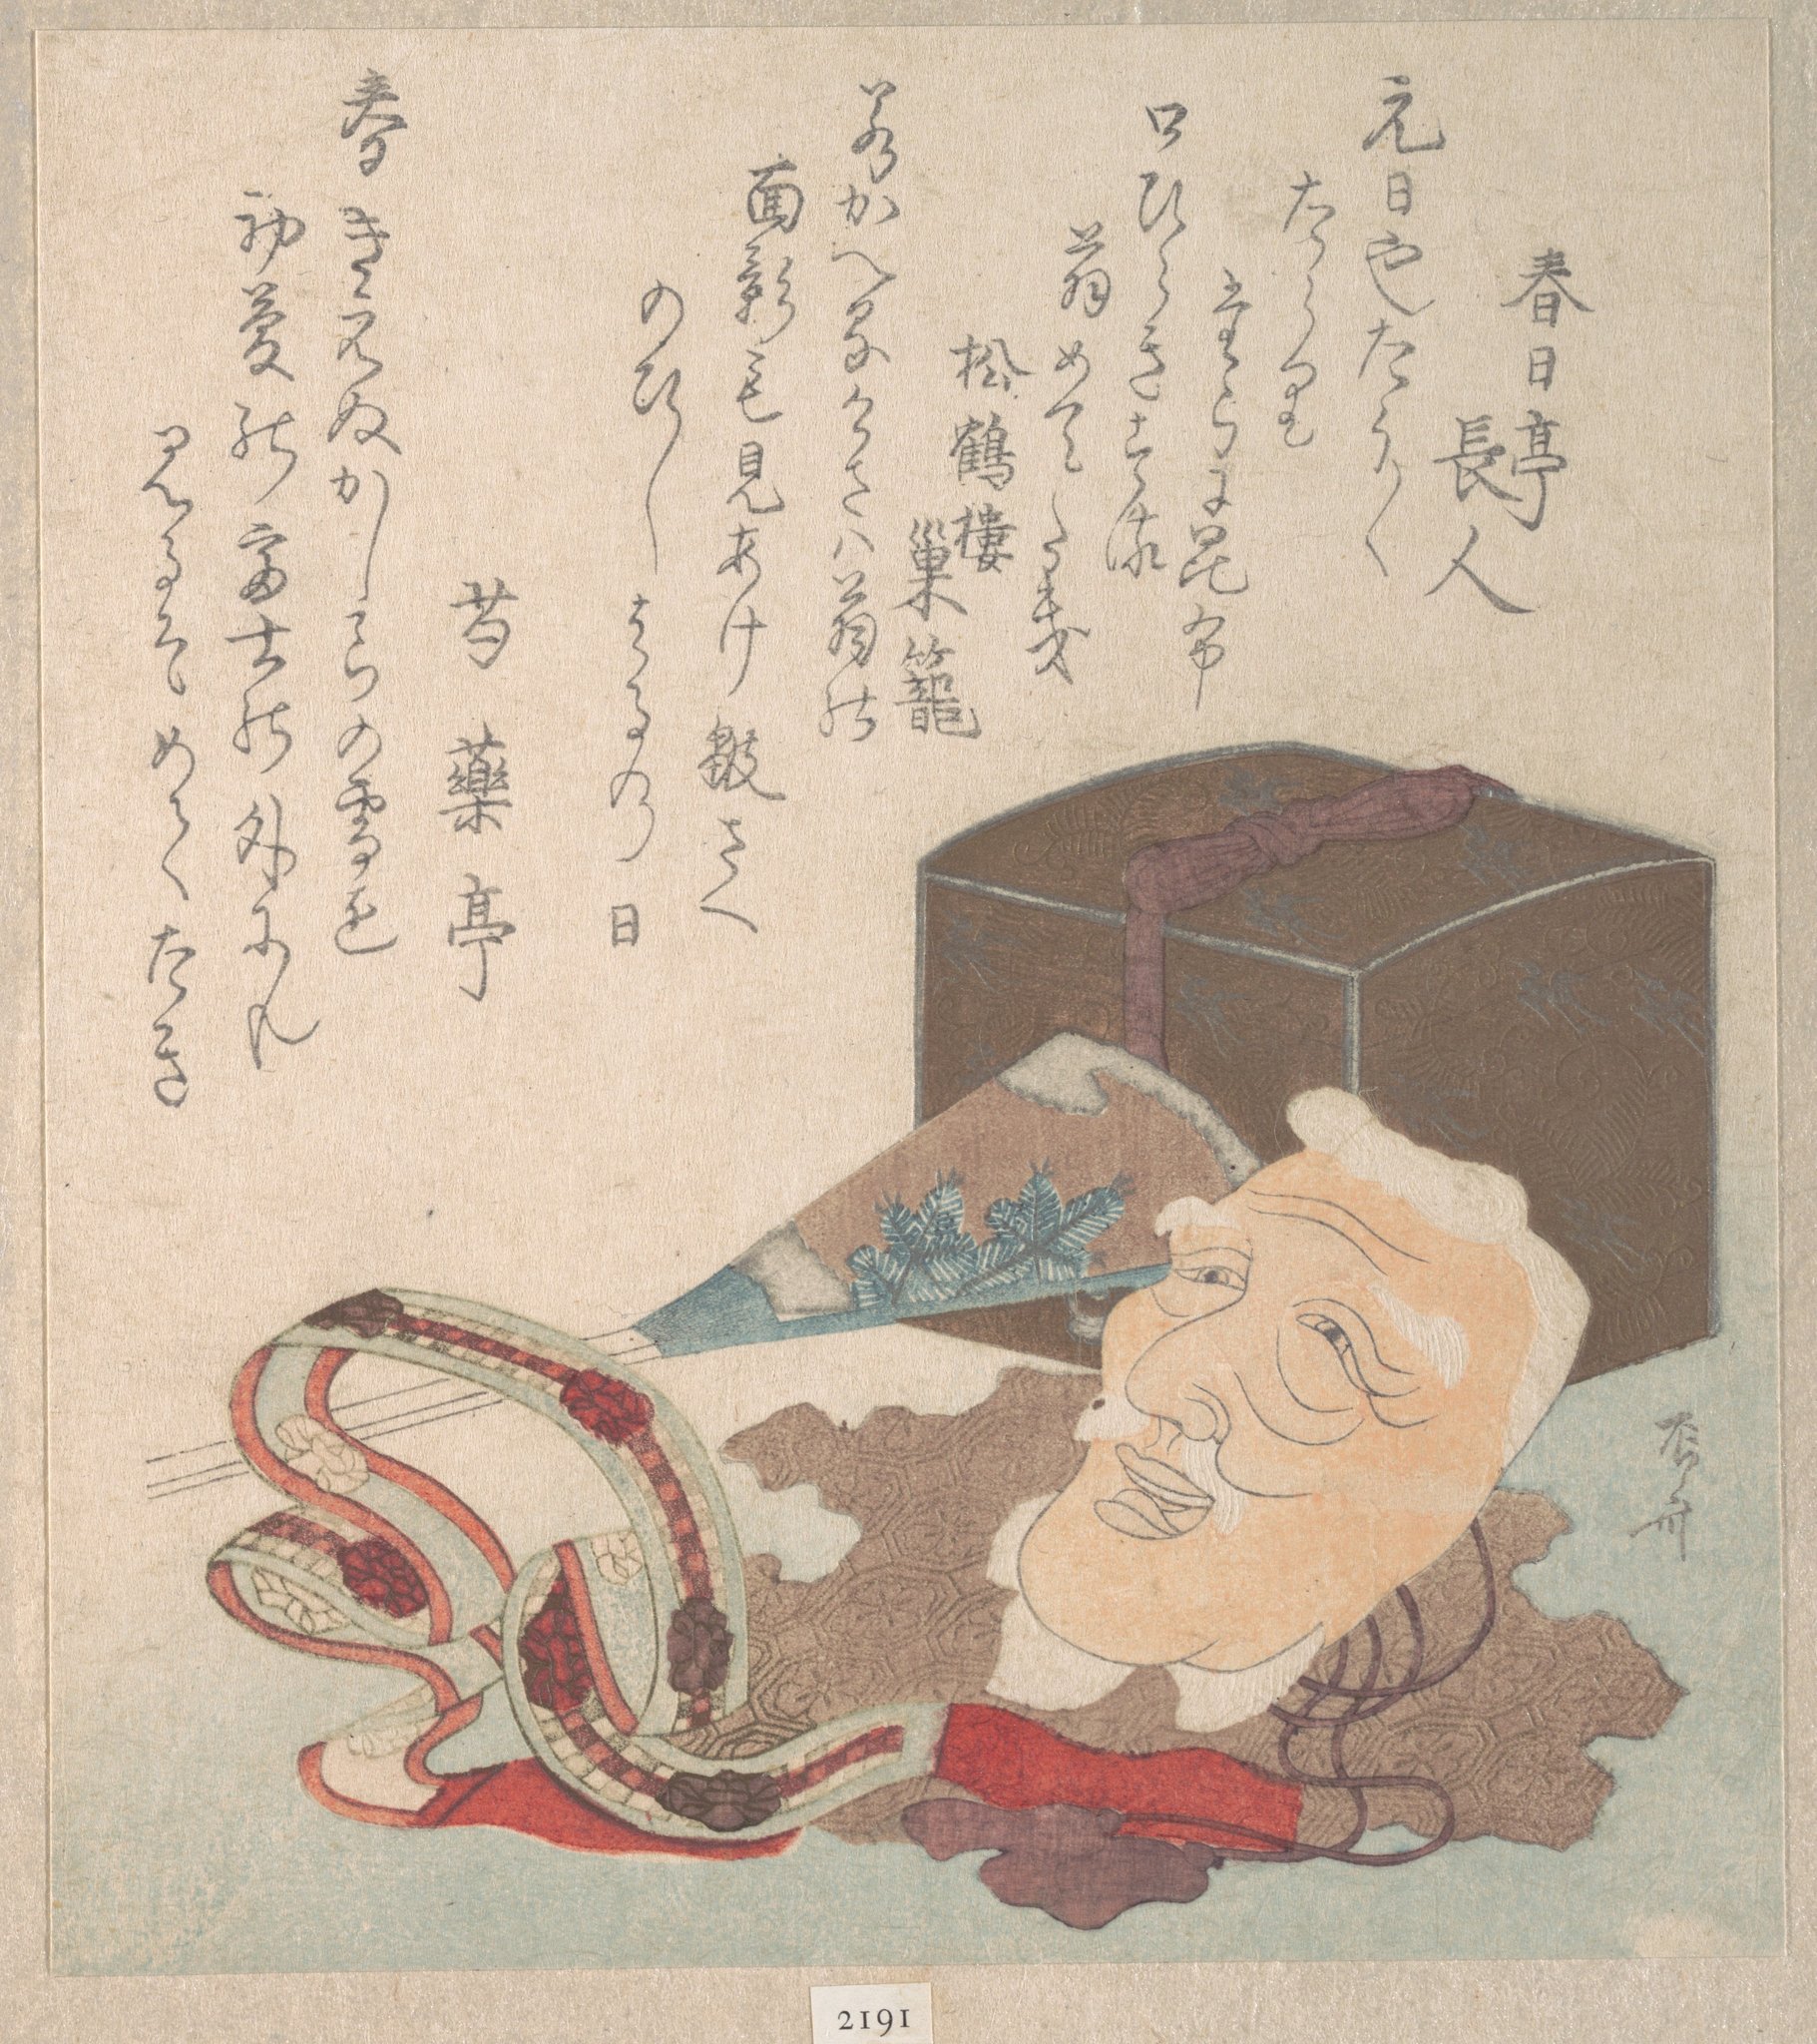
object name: print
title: Mask and Other Objects for the Noh Dance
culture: japanese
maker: ryūryūkyo shinsai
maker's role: artist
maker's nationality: japanese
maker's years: 1799-1823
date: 1750-1835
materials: ink, paper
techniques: surimono, woodblock print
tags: masks,fans